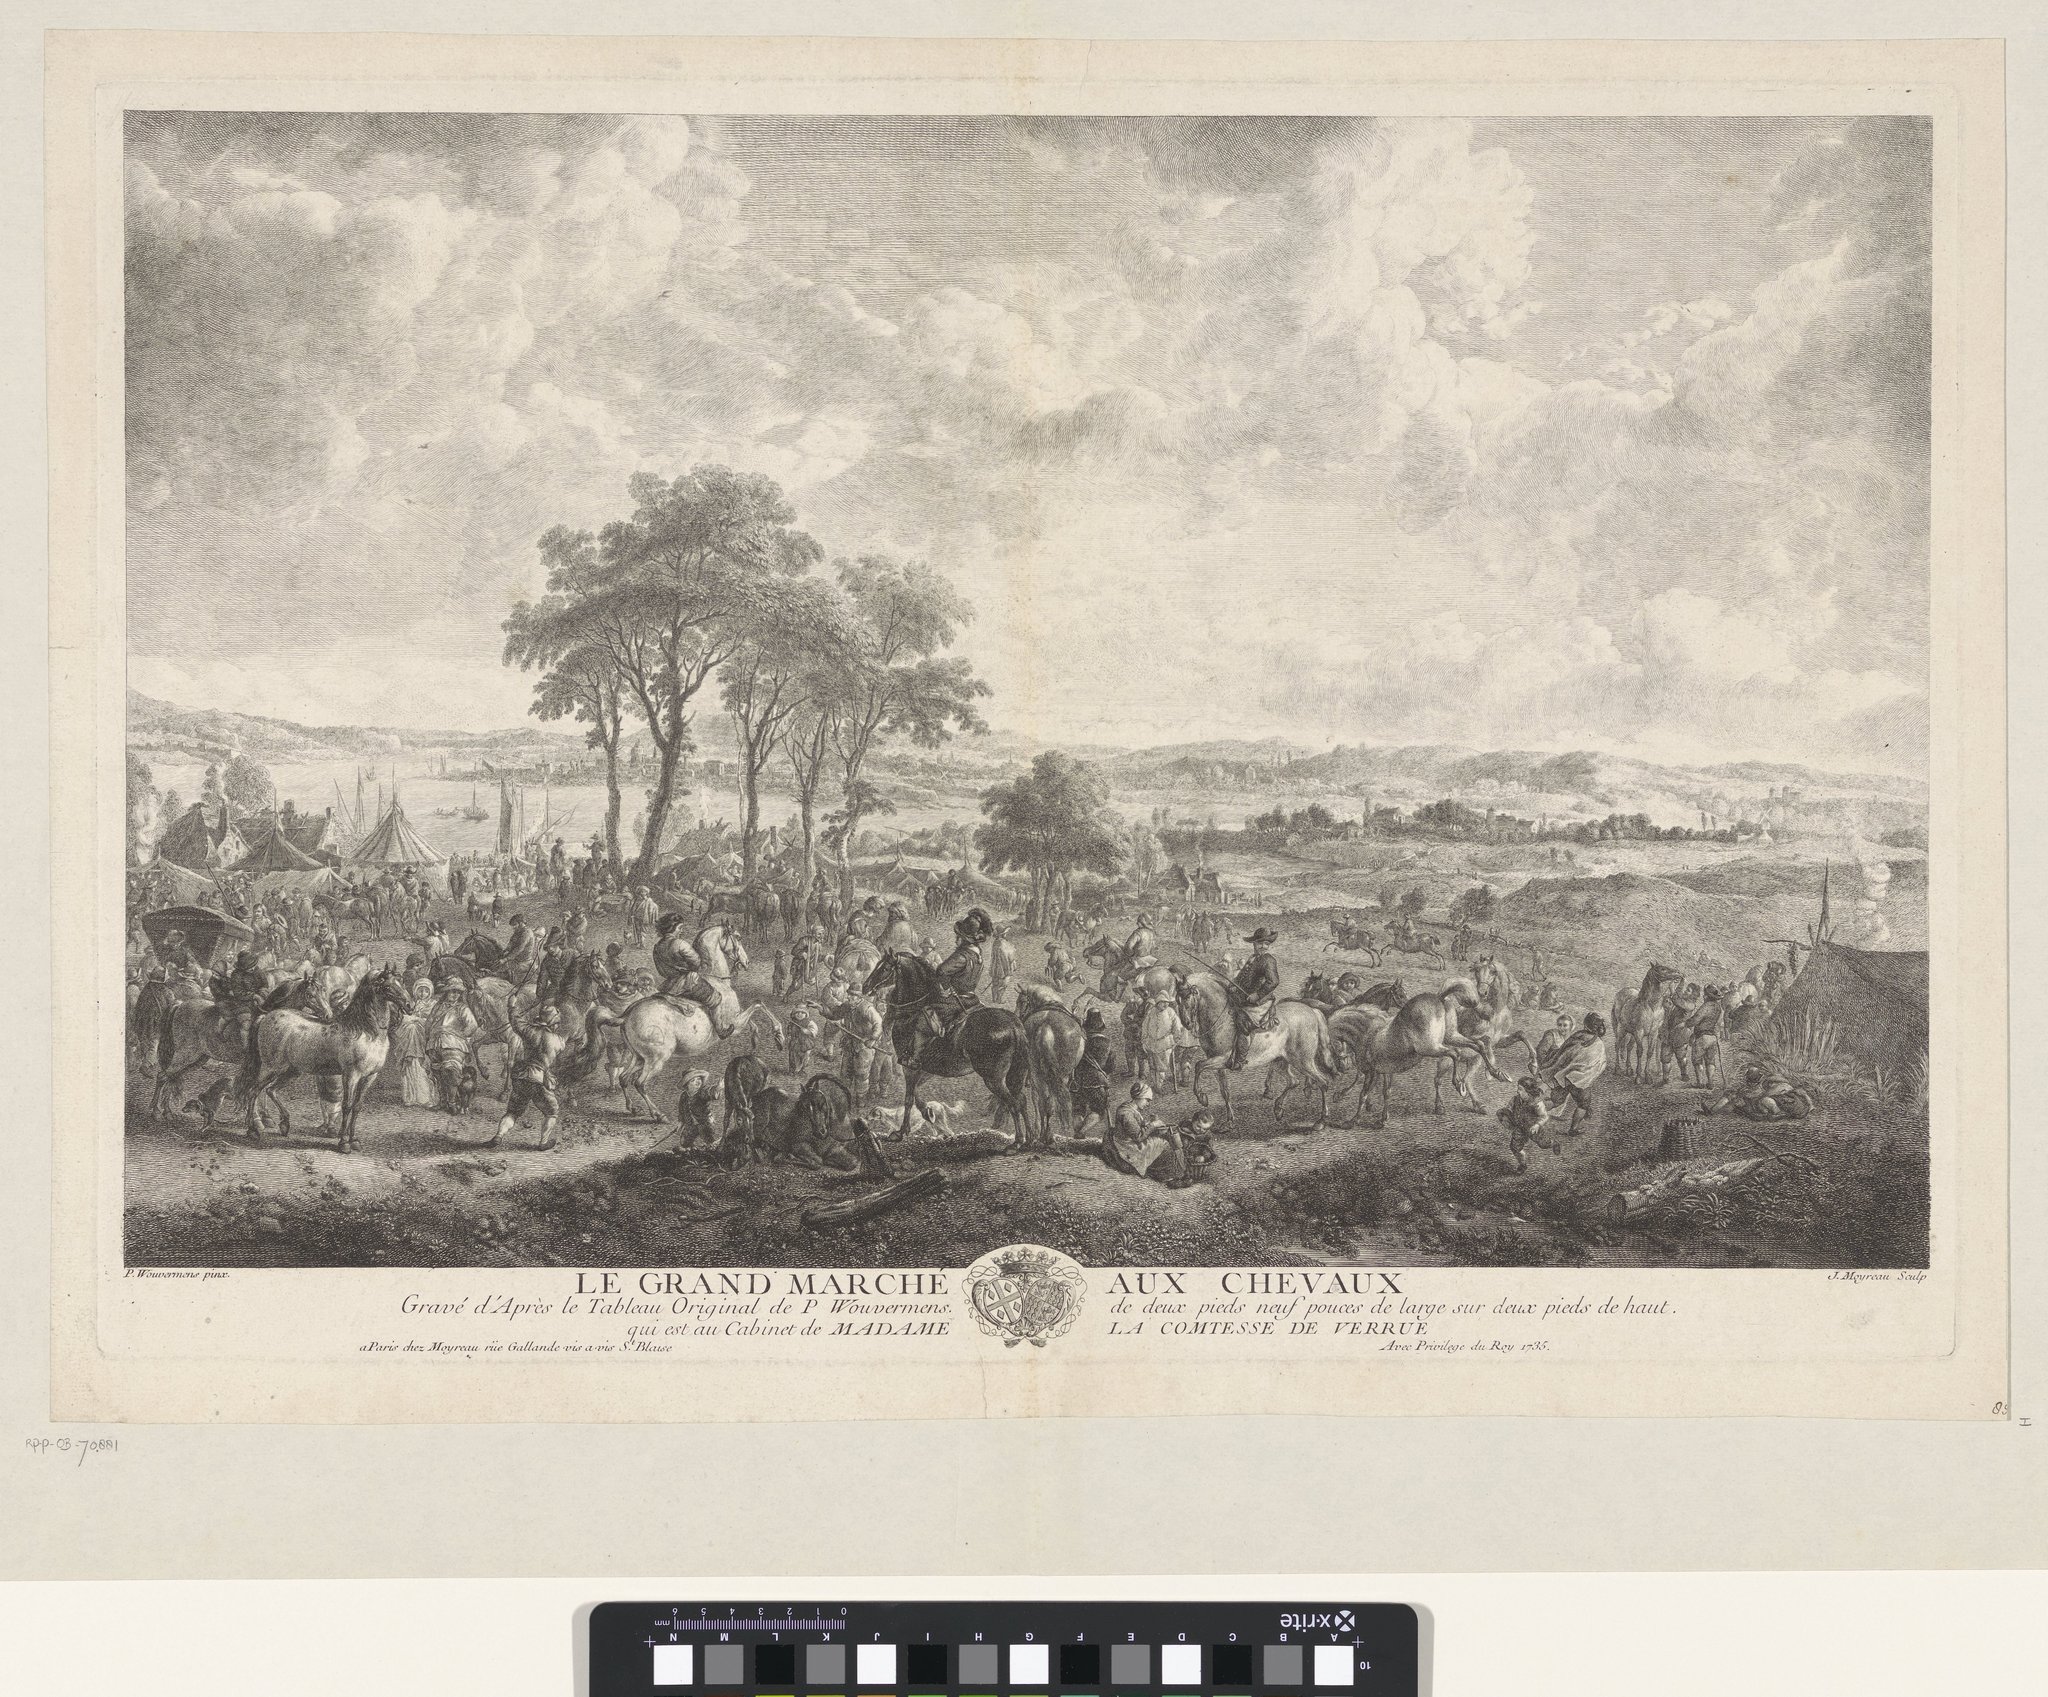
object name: print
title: Grote paardenmarkt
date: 1735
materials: paper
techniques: engraving, etching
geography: france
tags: city-view, and landscape with man-made constructions, horse, market, armorial bearing, heraldry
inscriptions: collector's mark: Lugt 240, number: ‘8[5/9?]’